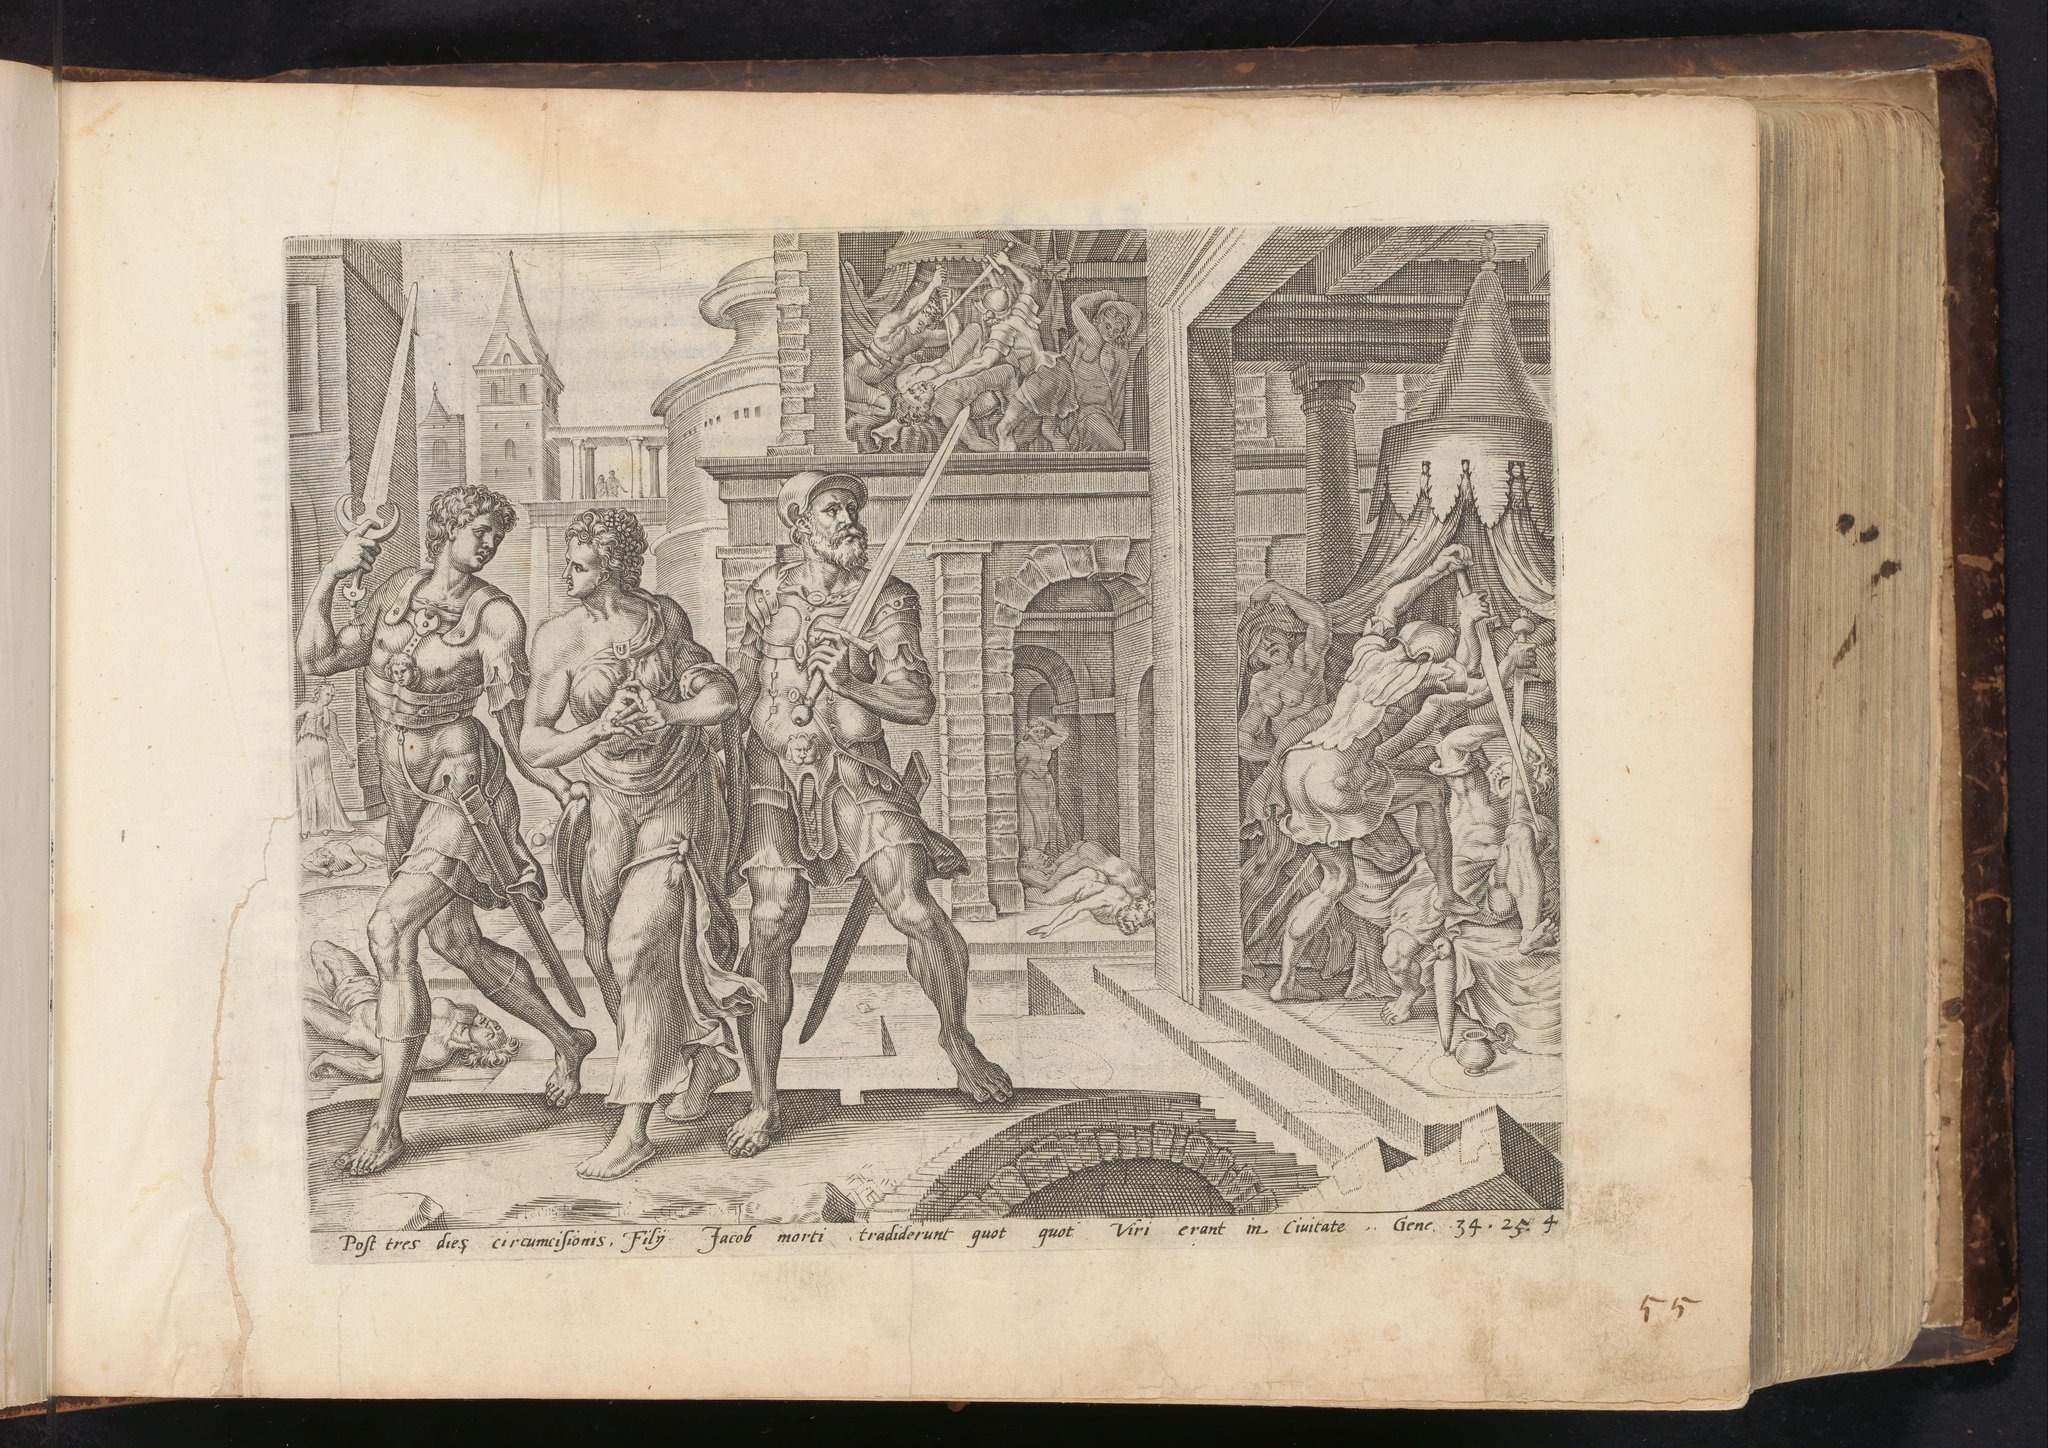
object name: album leaf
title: Simeon en Levi nemen Dina mee naar huis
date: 1585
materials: paper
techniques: engraving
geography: alkmaar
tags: simeon and levi kill all the shechemites and bring dinah home, while the other brothers plunder the city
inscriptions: number: ‘55’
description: Simeon en Levi nemen hun zus Dina mee naar huis, nadat zij wraak hebben genomen op Sichem, die hun zus had onteerd. Op de achtergrond doden de broers Sichem en zijn mannen, die na hun besnijdenis koortsig waren en niet terug konden vechten. Onderaan in de marge een verwijzing in het Latijn naar de Bijbeltekst in Gen. 34:25. Deze prent maakt deel uit van een album.